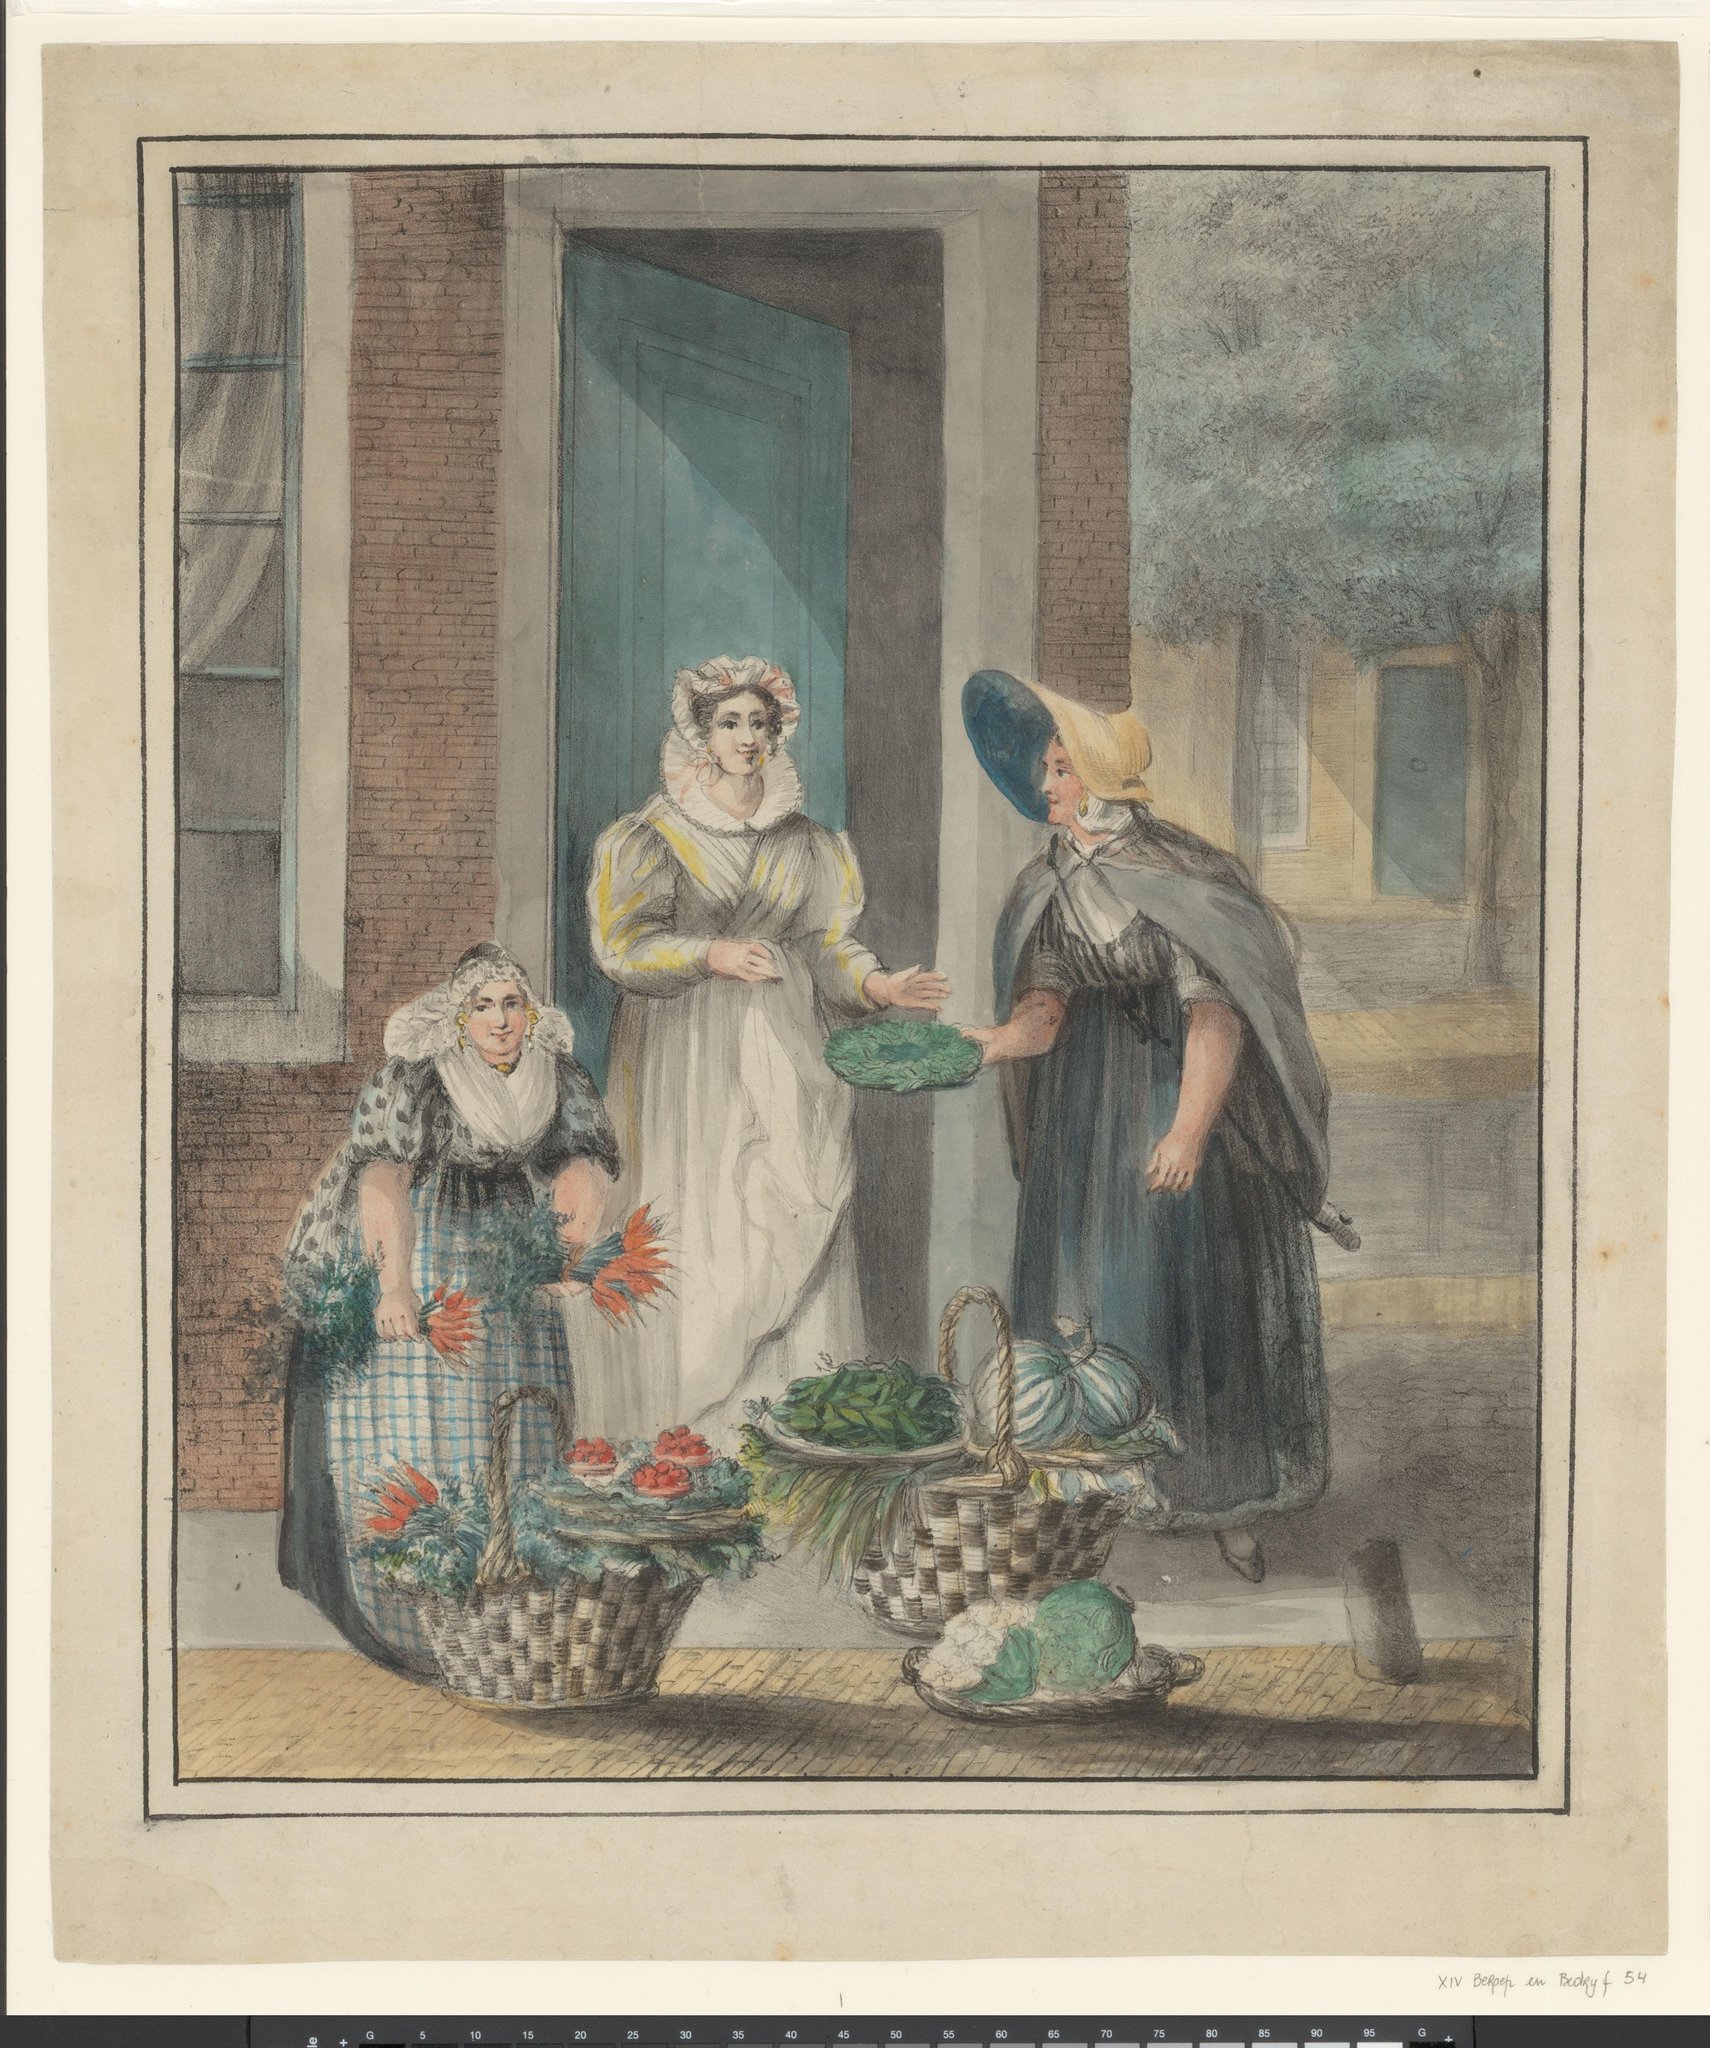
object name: print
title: Twee groenteverkoopsters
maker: Anonymous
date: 1800-1850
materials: paper, watercolor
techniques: hand coloring, lithograph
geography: netherlands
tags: vegetables, merchant, salesman - bb - women engaged in trade and commerce, selling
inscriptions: collector's mark: Lugt 1641, collector's mark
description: Een dame aan de deur met twee groenteverkoopsters. Op de grond twee grote manden met verschillende groenten. Onderwerpsrubrieken binnen de Atlas Zeden en Gewoonten: Beroep en bedrijf. Vrouwelijk beroep en bedrijf. Eet- en drinkwaren.